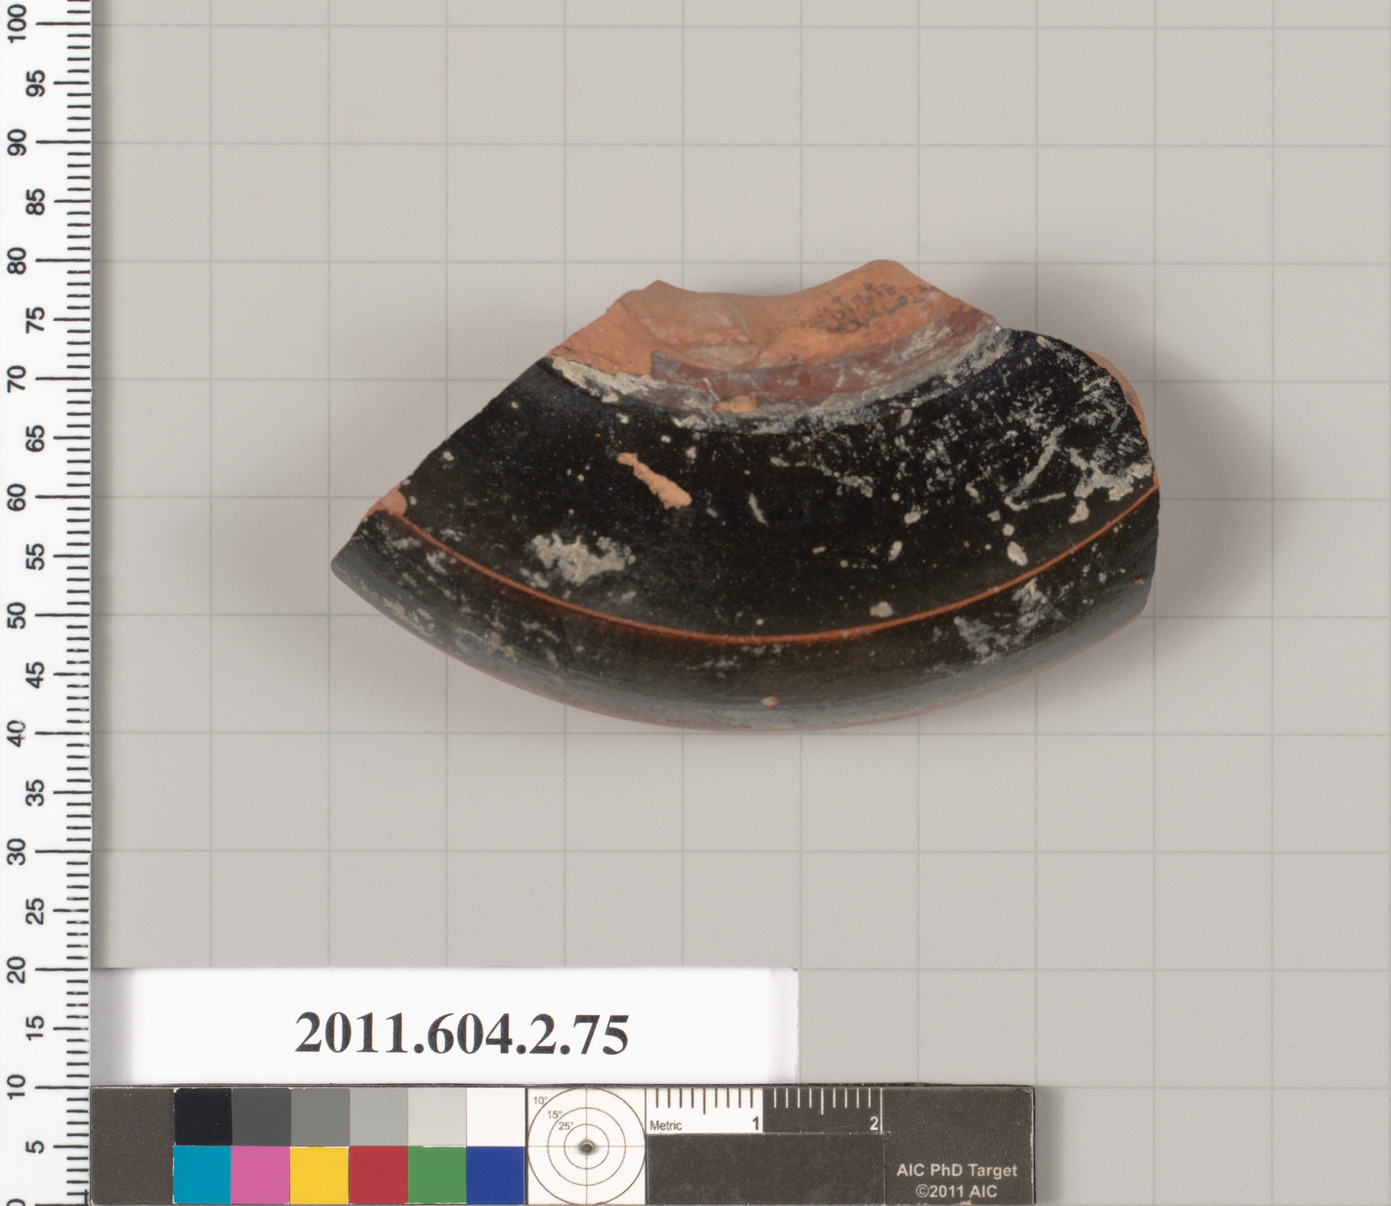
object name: neck amphora fragment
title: Terracotta fragment of a neck-amphora (jar)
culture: greek, attic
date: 534-468 BCE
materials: terracotta